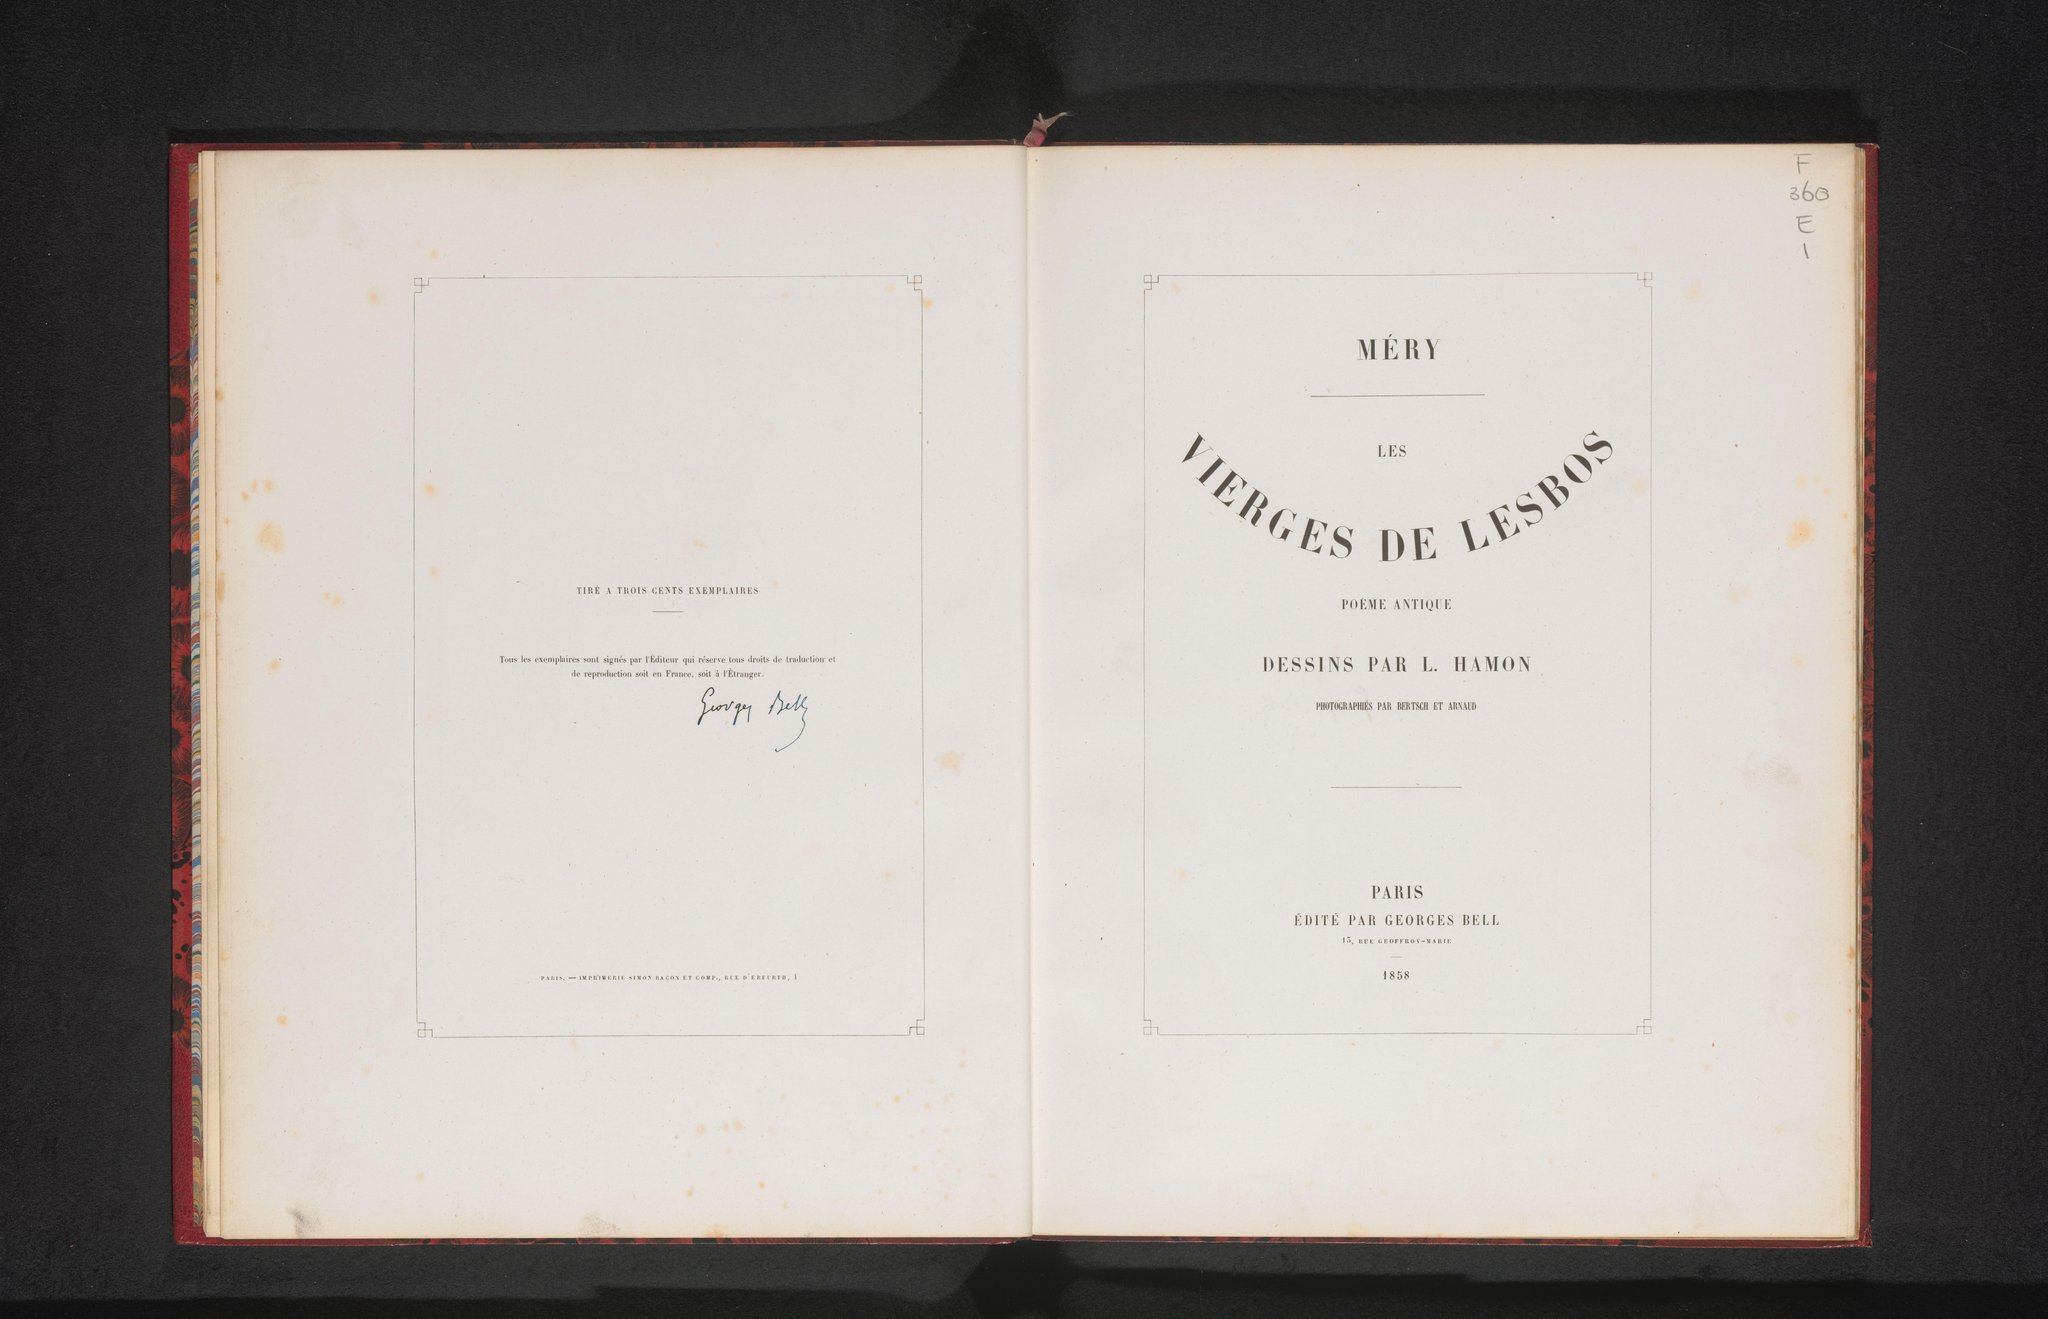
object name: book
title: Les vierges de Lesbos : poème antique / Méry; dessins par L. Hamon; photographiés par Bertsch et Arnaud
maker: jean-louis hamon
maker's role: painter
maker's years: 1821-1874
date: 1858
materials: cardboard, linen, paper, photographic support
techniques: marbled paper, printing, salted paper print, marbling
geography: london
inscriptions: annotation: ‘FEB/ 1999’, bookplate: ‘EX-LIBRIS/ E. DÉLICOURT’, number: ‘16000,-’